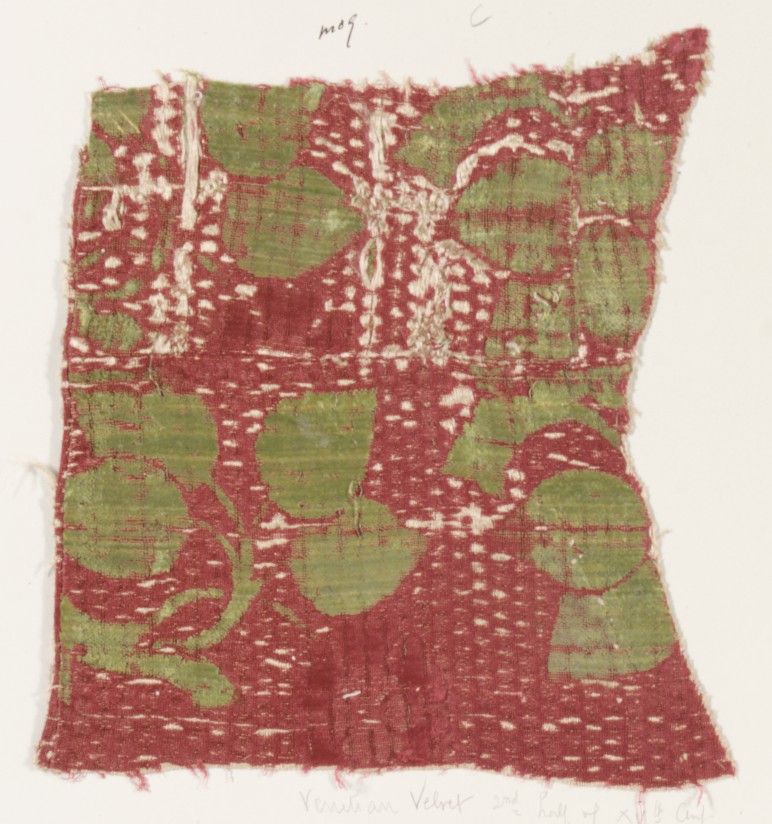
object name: fragment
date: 1467-1500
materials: metal thread, silk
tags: leaves